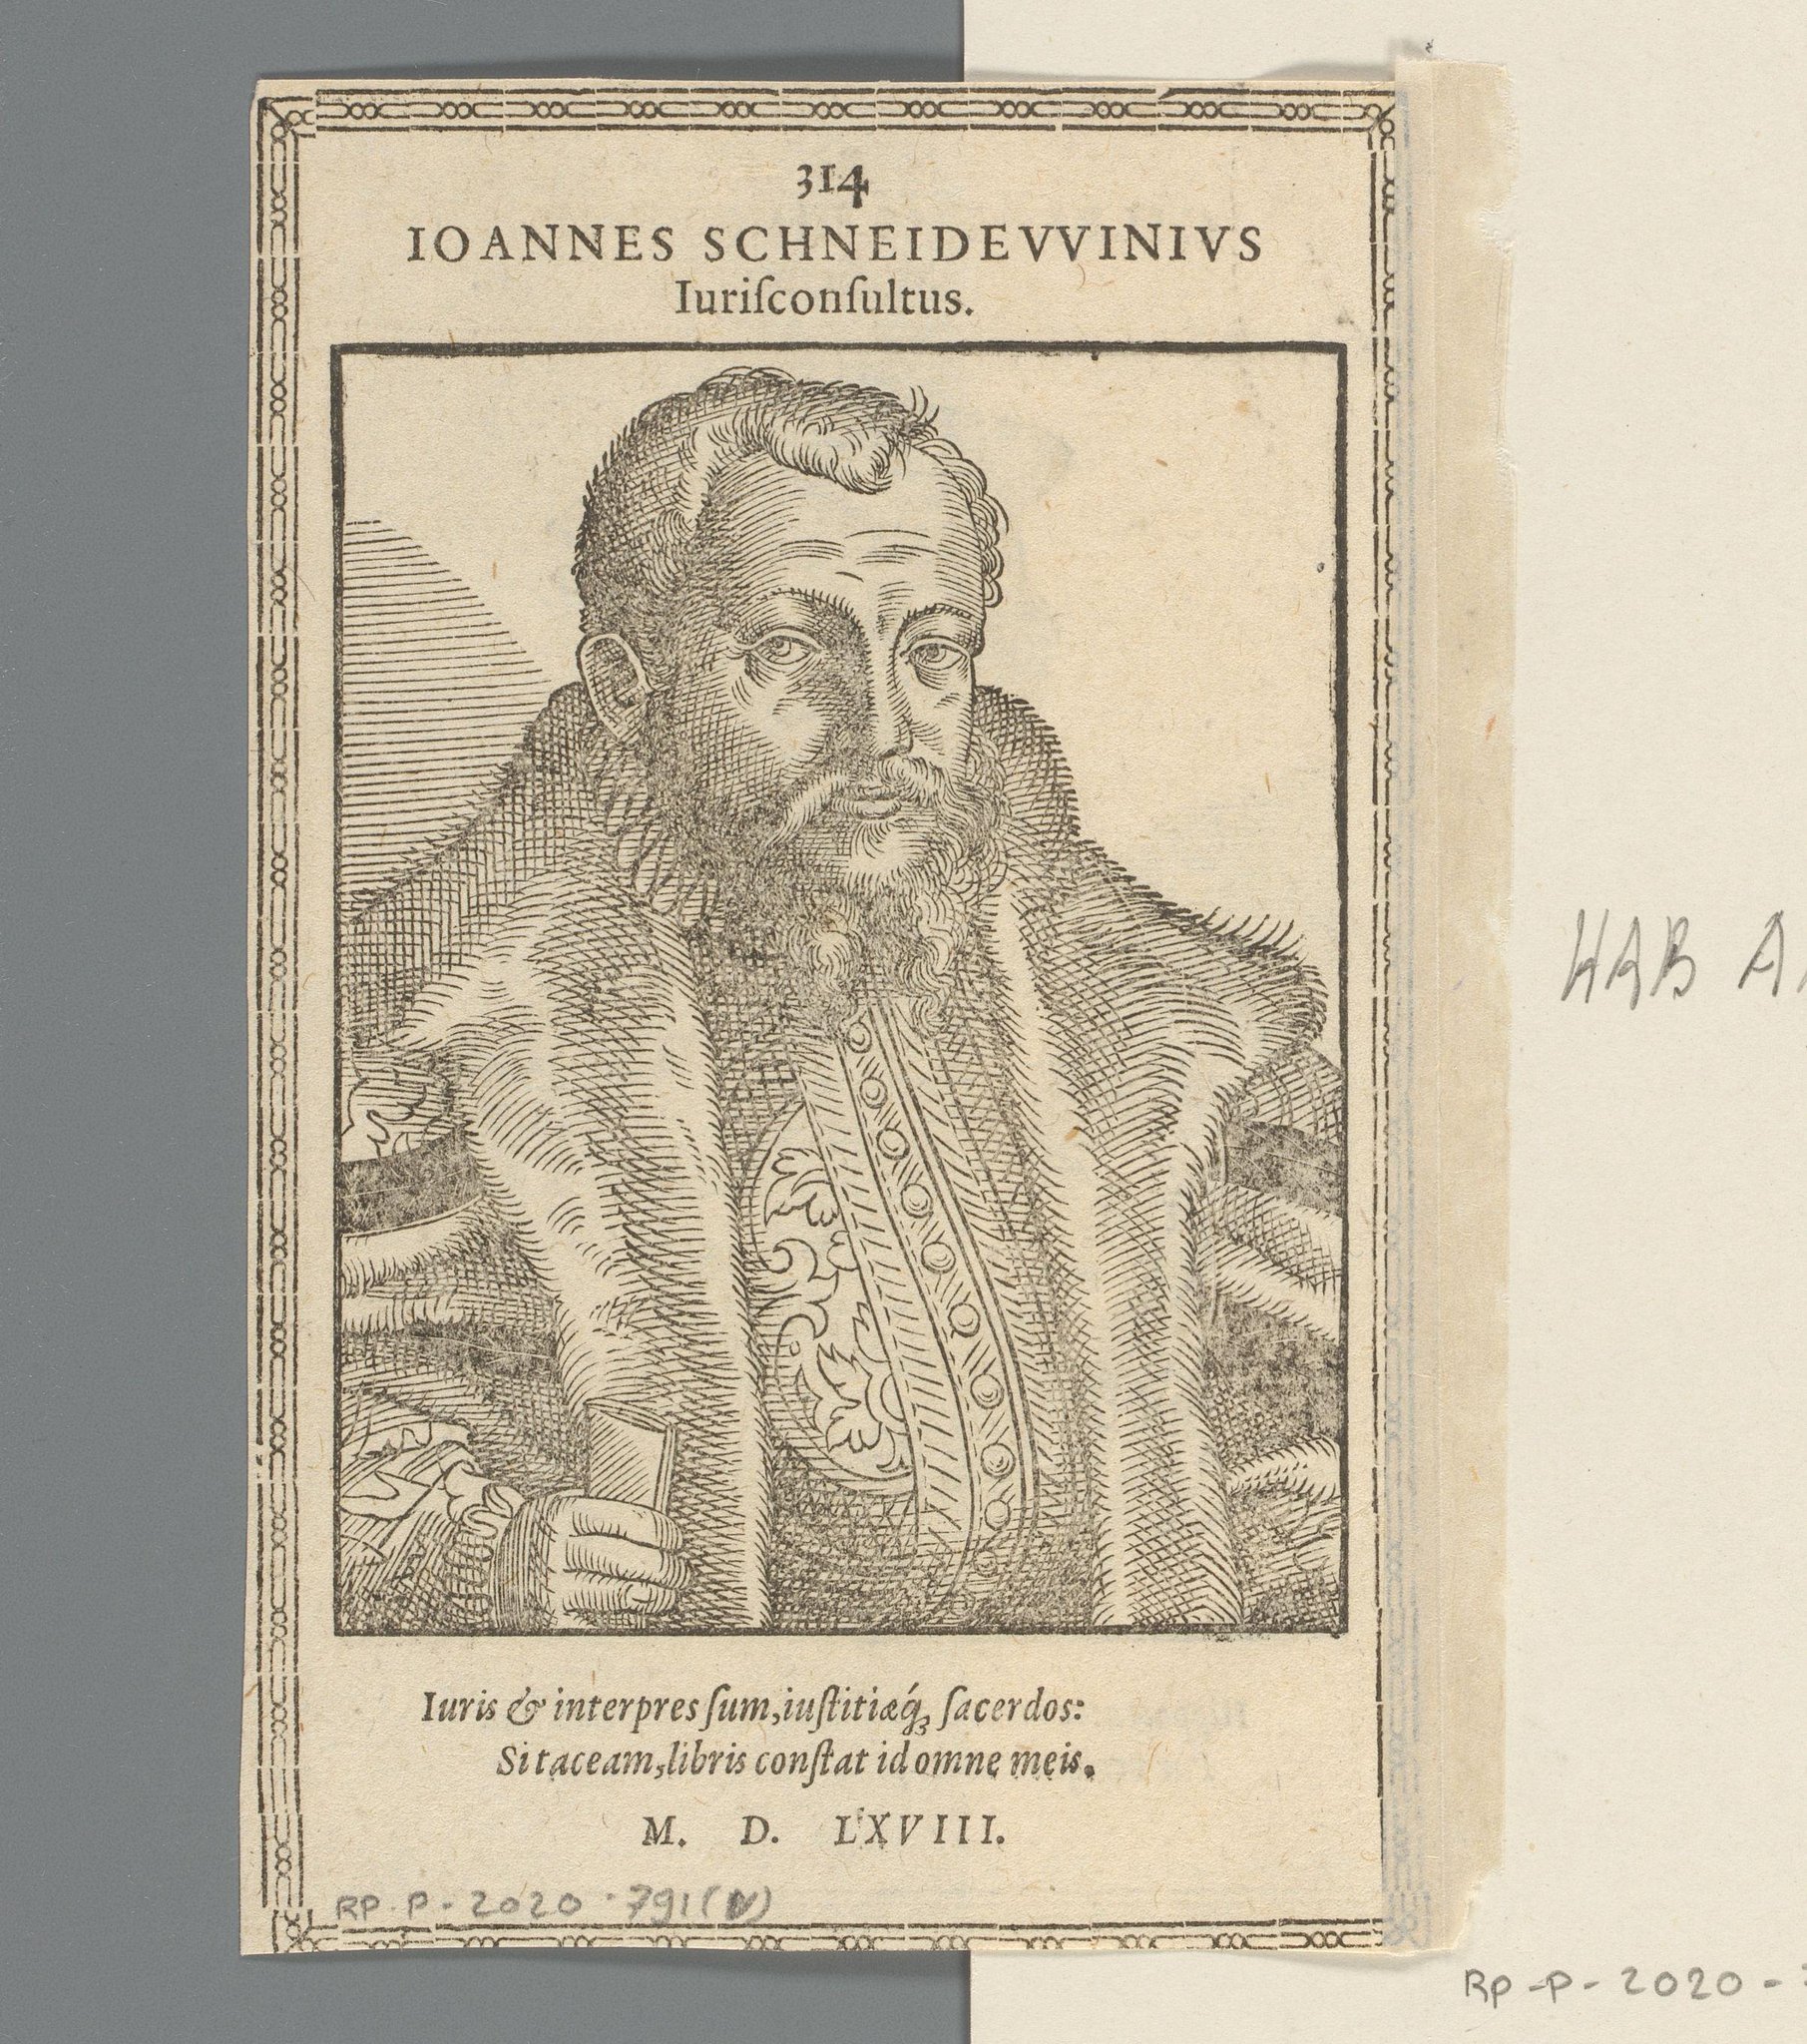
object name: print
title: Portret van Johann Schneidewein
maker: bernhard jobin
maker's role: printer, publisher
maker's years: 1545-1593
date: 1590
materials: paper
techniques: letterpress printing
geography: straatsburg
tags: historical persons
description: Prent uit: Reusner, Nikolaus. Icones sive imagines virorum literis illustrium (...). Straatsburg: Bernhard Jobin, 1590, p. 314. Prent voor het eerst verschenen in de eerste editie van 1587. Prent ook gebruikt in latere publicaties.